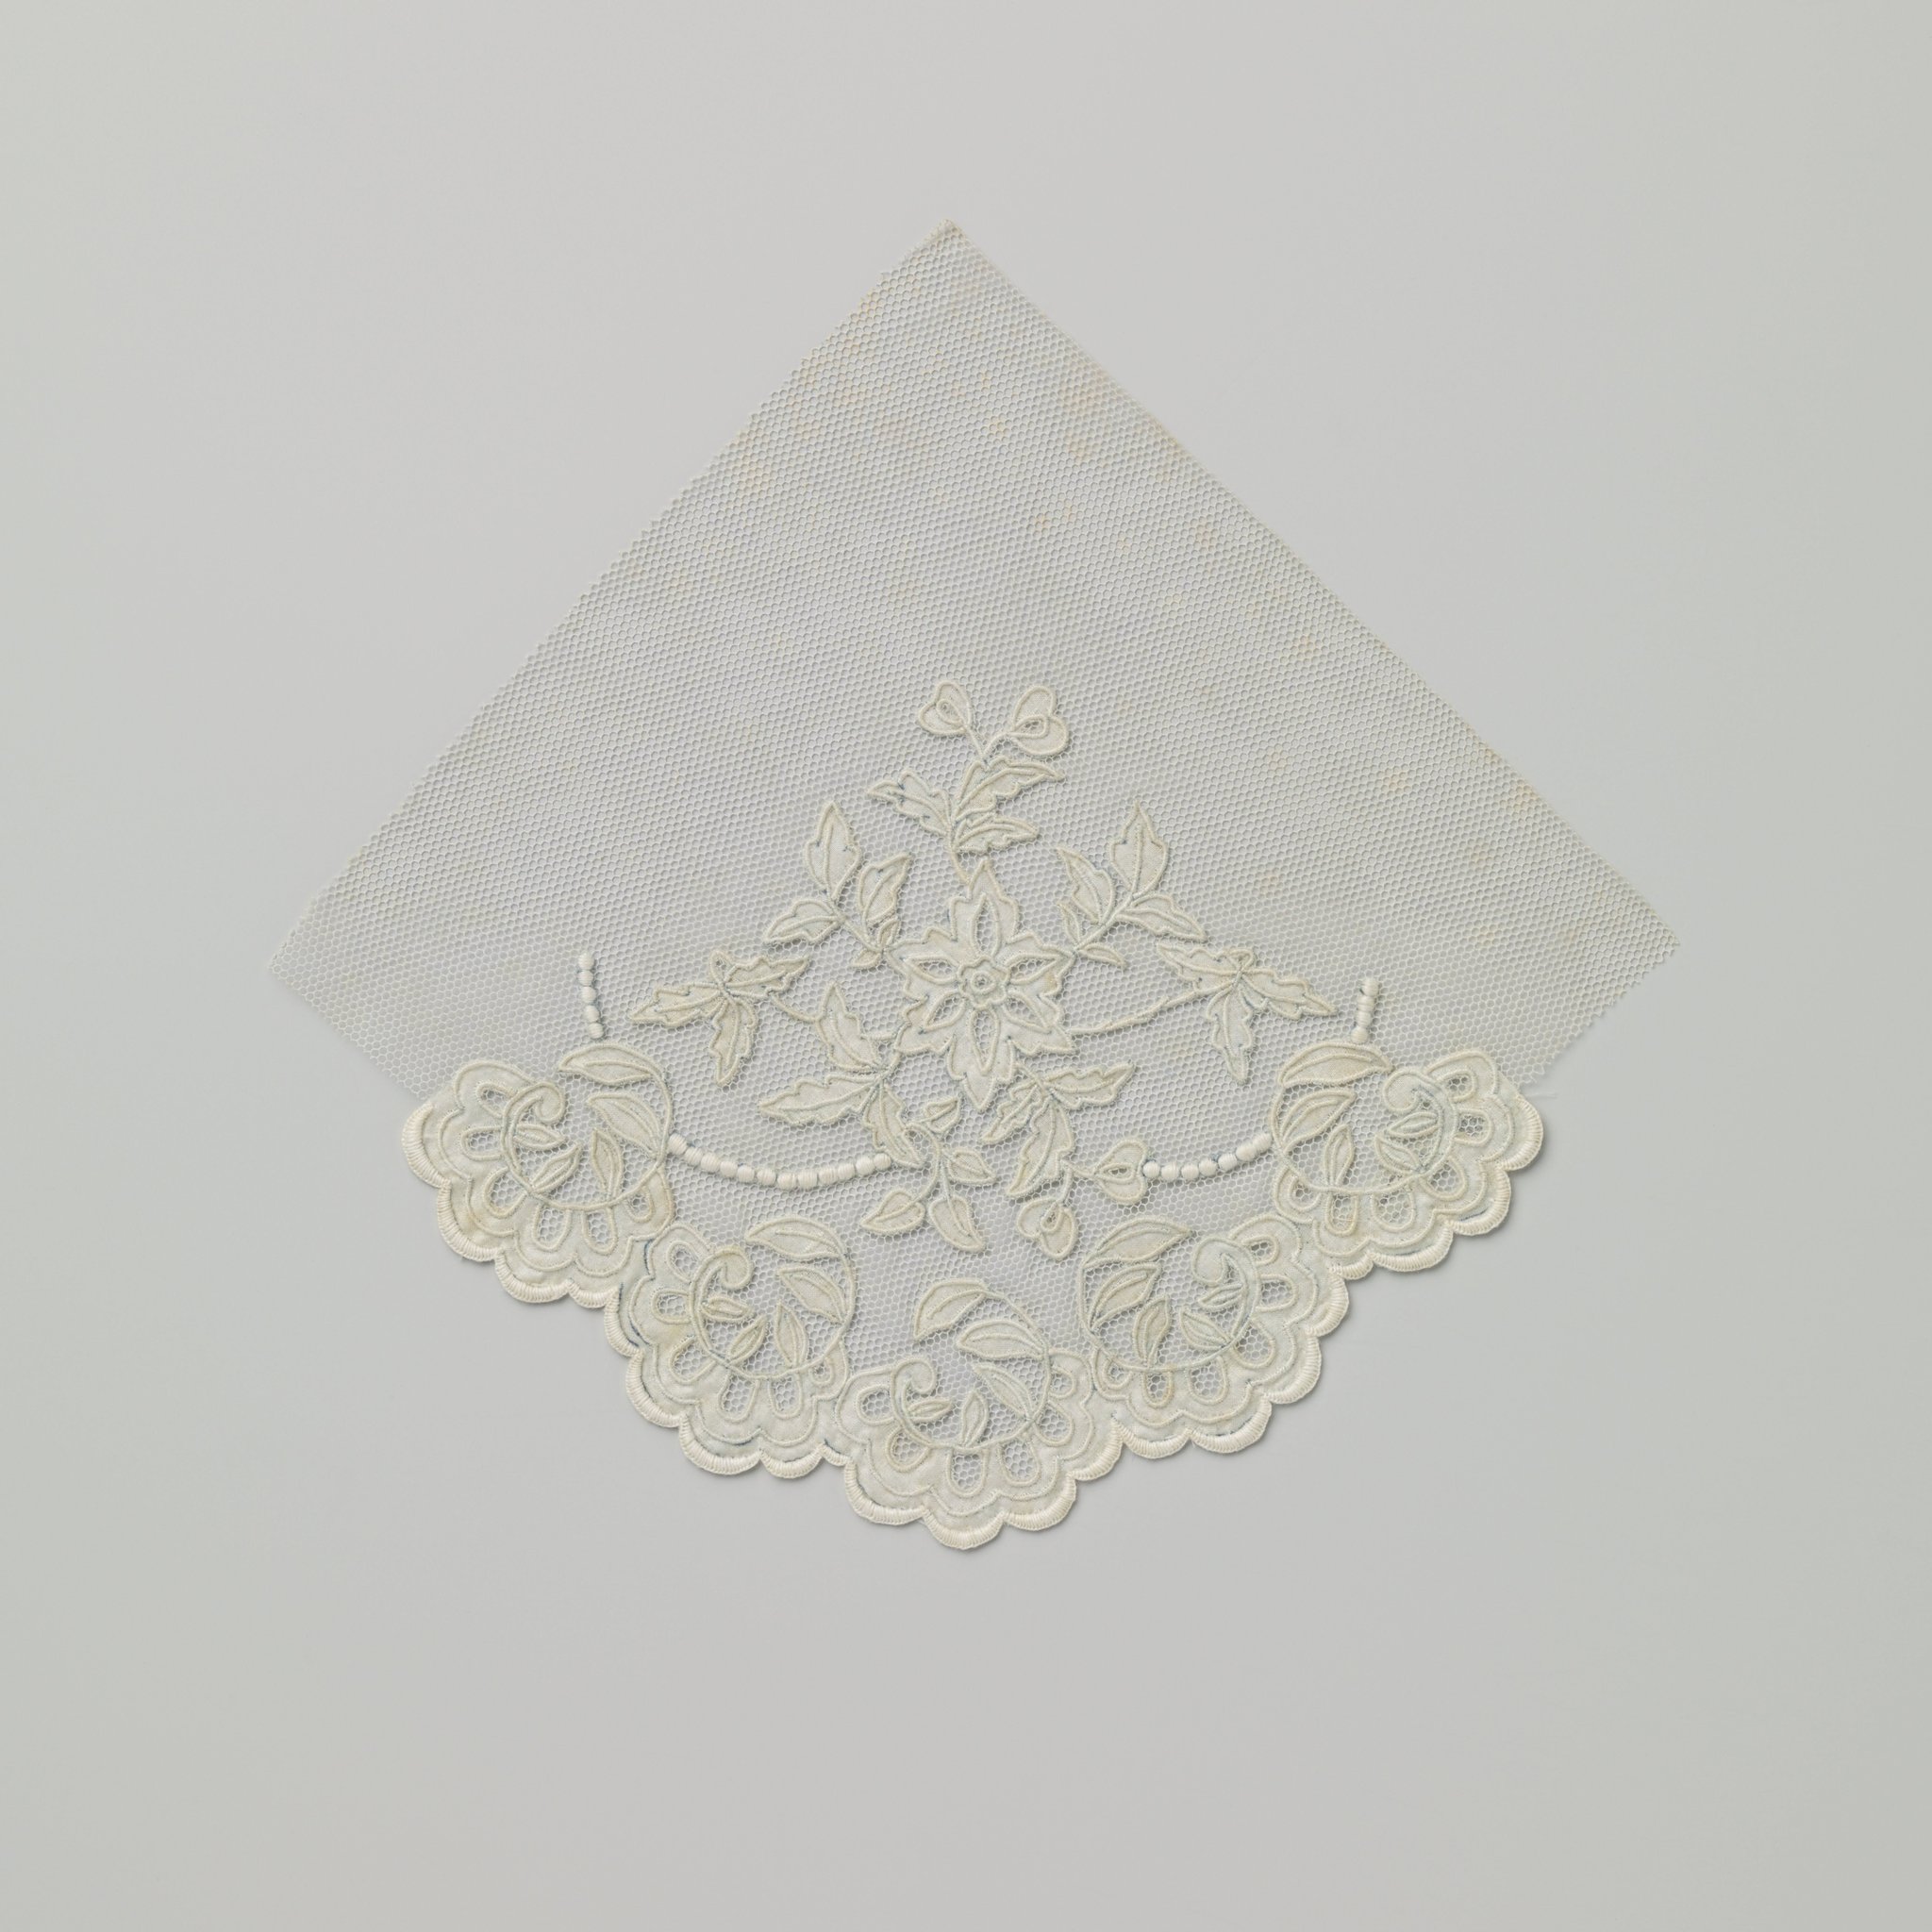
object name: werkstuk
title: Werkstuk voor Diploma fraaie handwerken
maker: geesje smid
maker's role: artisan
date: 1890-1900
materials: textile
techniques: embroidered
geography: netherlands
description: Geschulpt hoekmotief van batist geappliceerd op tule met een kettingsteek, versierd met een bloemtakje.